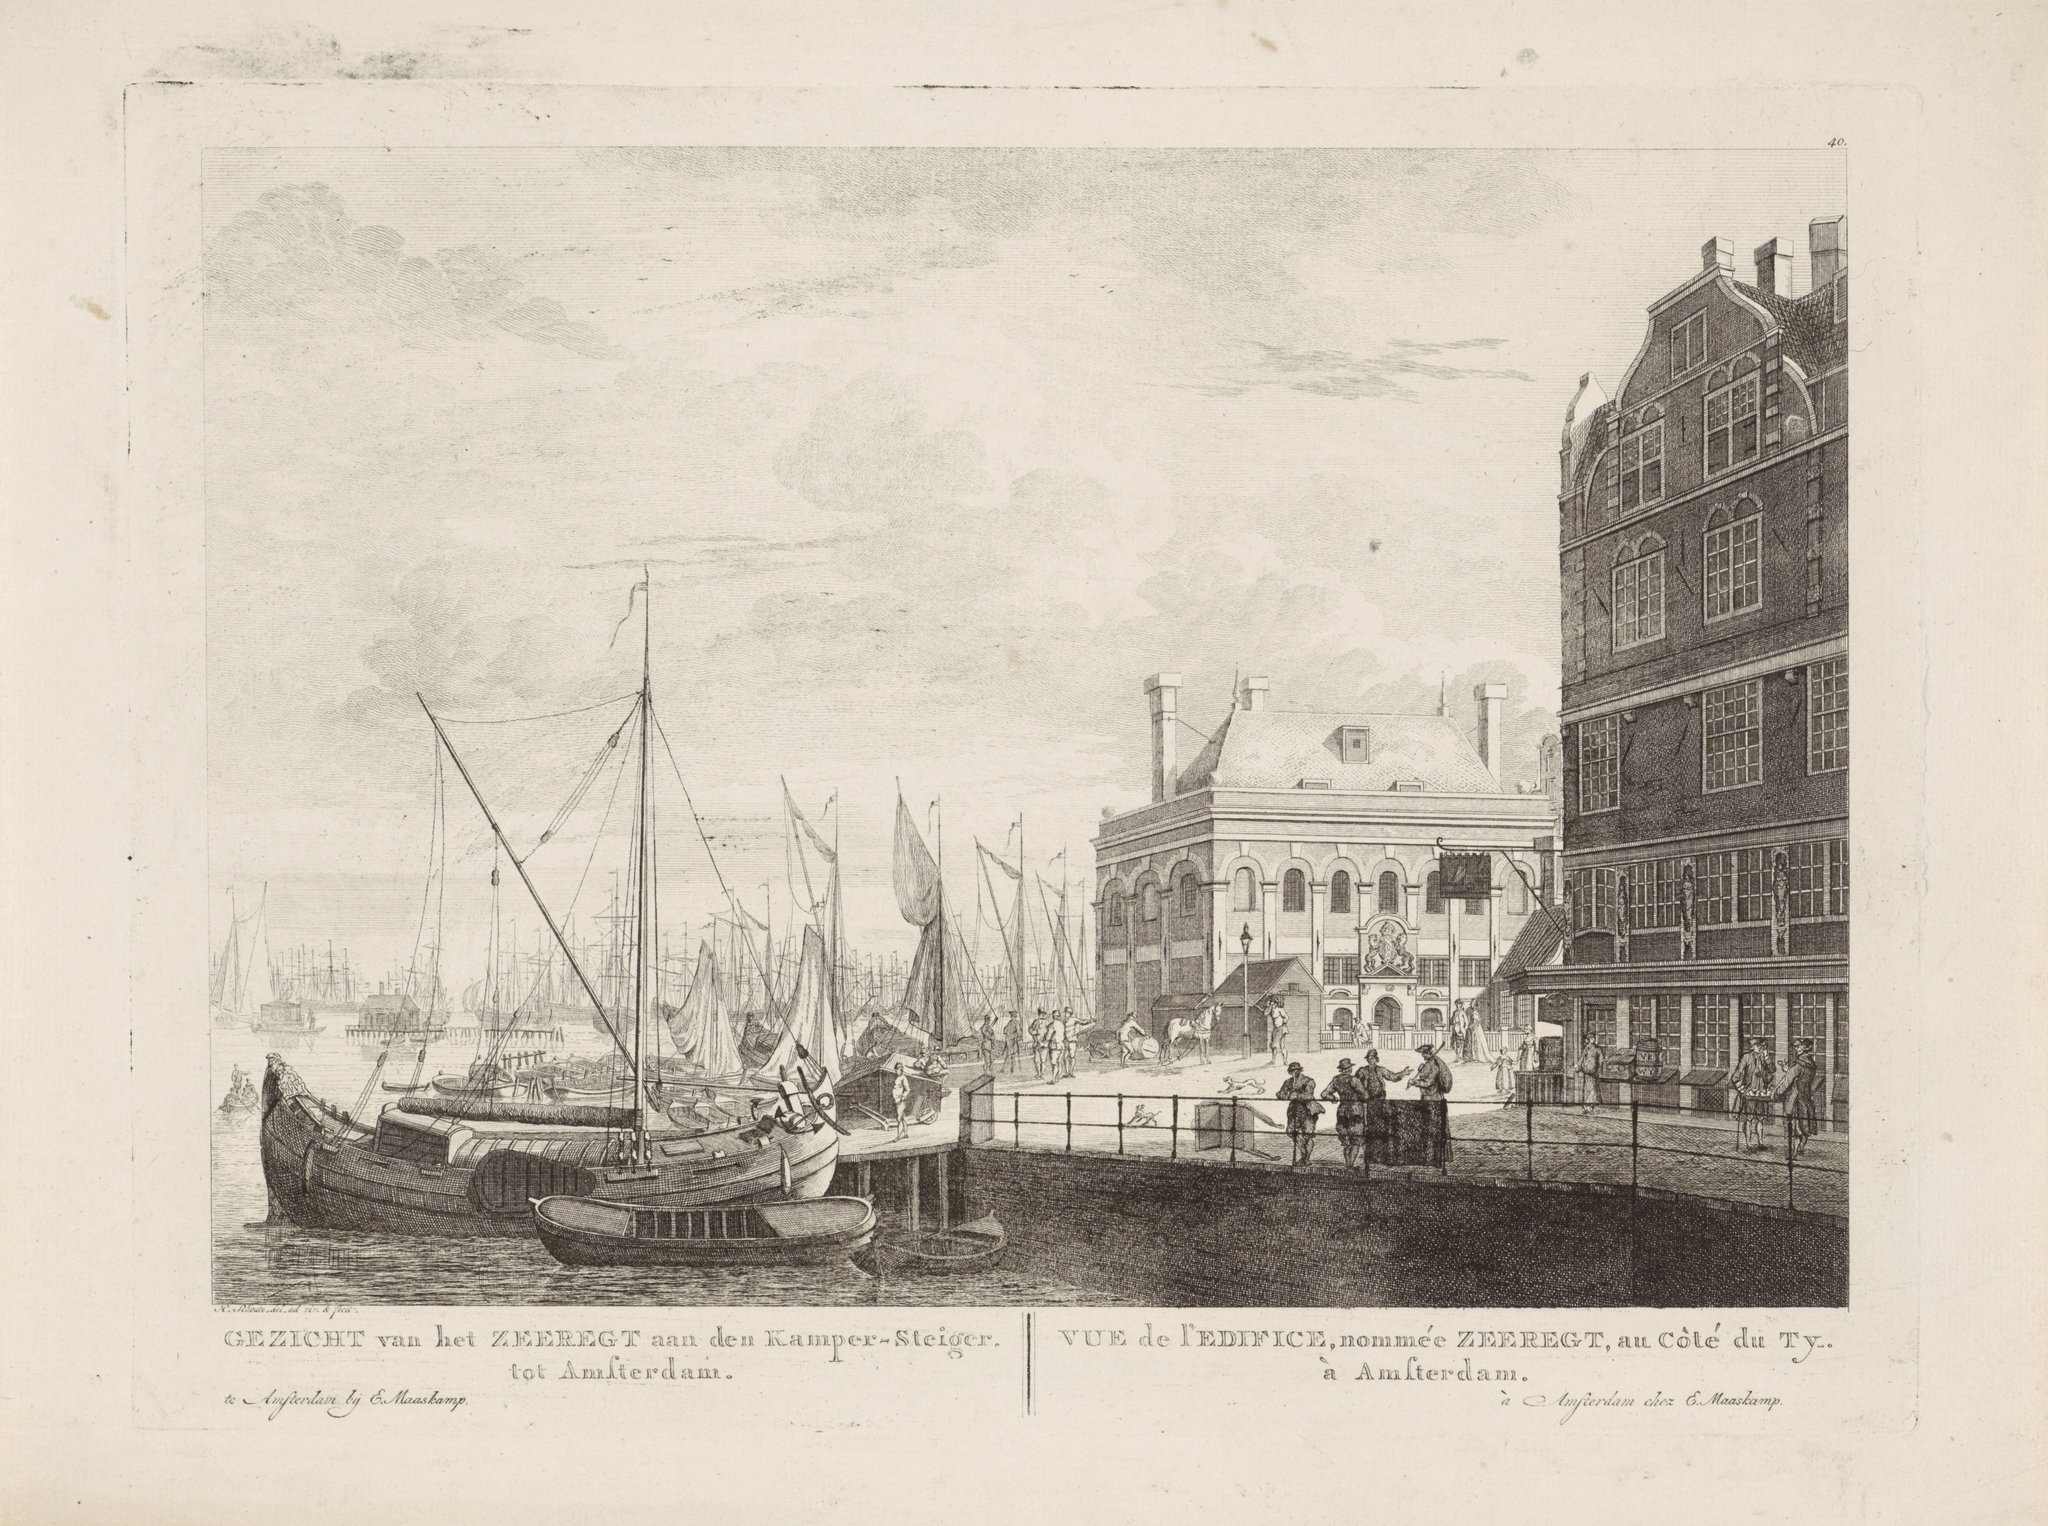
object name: print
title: Gezicht op het gebouw Zeerecht aan de Kampersteiger te Amsterdam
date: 1805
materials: paper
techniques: engraving, etching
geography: amsterdam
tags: harbour, court building, canals, waters (in city) (+ city(-scape) with figures, staffage), street (+ city(-scape) with figures, staffage)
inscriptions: collector's mark: Lugt 2166, collector's mark: Lugt 2760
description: Deze prent is ook gebruikt in de zogenaamde Atlas van Fouquet.* Pierre Fouquet gaf vanaf 1760 stadsgezichten van Amsterdam - naar tekeningen van verschillende kunstenaars, gemaakt door verschillende prentmakers - uit. Deze prenten werden aanvankelijk los of in series verkocht. Zoals toen gebruikelijk kon de koper de prenten zelf laten inbinden. Hiertoe gaf Fouquet tussen 1778 en 1783 een titelblad, plattegrond en inhoudsopgave van de tot dusver 100 uitgegeven prenten uit (1). Gezien de inhoud afhankelijk was van wat de koper had verzameld verschilt de inhoud van de verschillende bewaarde Fouquetatlassen onder deze titel sterk. Ook zijn er exemplaren bekend waar tevens andere prenten aan zijn toegevoegd. Omdat er behoefte bleek aan uitleg bij de platen werd in 1783 een nieuwe versie van de atlas uitgegeven, aangevuld met tekst en twee prenten. De aangegeven volgorde veranderde maar de platen van de al eerder uitgegeven prenten bleven ongewijzigd. Deze uitgave werd in opdracht van Fouquet gedrukt bij Daniël Jean Changuion en Petrus den Hengst (2). Een tiental platen werd bijgewerkt en verscheen, met nieuw impressum, in het vervolg van Wagenaars geschiedenis van Amsterdam, uitgeven door Petrus Conradi en Folkert van der Plaats (3). Een aantal jaar na het overlijden van Fouquet kwam Evert Maaskamp met een nieuwe uitgave van de atlas, met verbeterde tekst en toevoeging van twee prenten. Op alle platen verwijderde hij het oude en liet hij zijn eigen impressum zetten (4). De huidige staat van de prent komt voor in de onder (4) genoemde publicatie. * Onder de Atlas van Fouquet of Fouquetatlas verstaan we de hieronder vermelde publicaties (1), (2) en (4). (1). Afbeeldingen van de wyd-vermaarde koopstad Amsterdam benevens des zelvs voornaamste gebouwen en gezigten alle naar het leeven getekend / Receuil des edifices les plus considerables et des plus belles vues, de la fameuse ville d'Amsterdam, dessinées d'après nature. Amsterdam: Pierre Fouquet, 1778-1783. (2). Nieuwe atlas, van de voornaamste gebouwen en gezigten der stad Amsterdam, met derzelver beknopte beschryvingen. 2 delen. Amsterdam: Daniël Jean Changuion en Petrus den Hengst [in opdracht van Pierre Fouquet], 1783. (3). Stijl, Simon. Amsterdam, in zyne geschiedenissen, voorregten, koophandel, gebouwen, kerkenstaat, schoolen, schutterye, gilden en regeeringe, beschreeven. Om te dienen ten vervolge op het werk van Jan Wagenaar (…). 10 delen. Amsterdam en Harlingen: Petrus Conradi en Folkert van der Plaats, 1788-1801. (4). Nieuwe atlas, van de voornaamste gebouwen en gezigten der stad Amsterdam. Met derzelver beknopte beschryvingen. Amsterdam: Evert Maaskamp, 1805. * Het aantal vermelde staten is gebaseerd op het aantal gevonden staten. Mogelijk zijn er meer staten van deze prent. Zie RP-P-1921-290 voor eerste bekende staat. Zie RP-P-AO-25-81 en RP-P-1911-3485 voor tweede bekende staat.